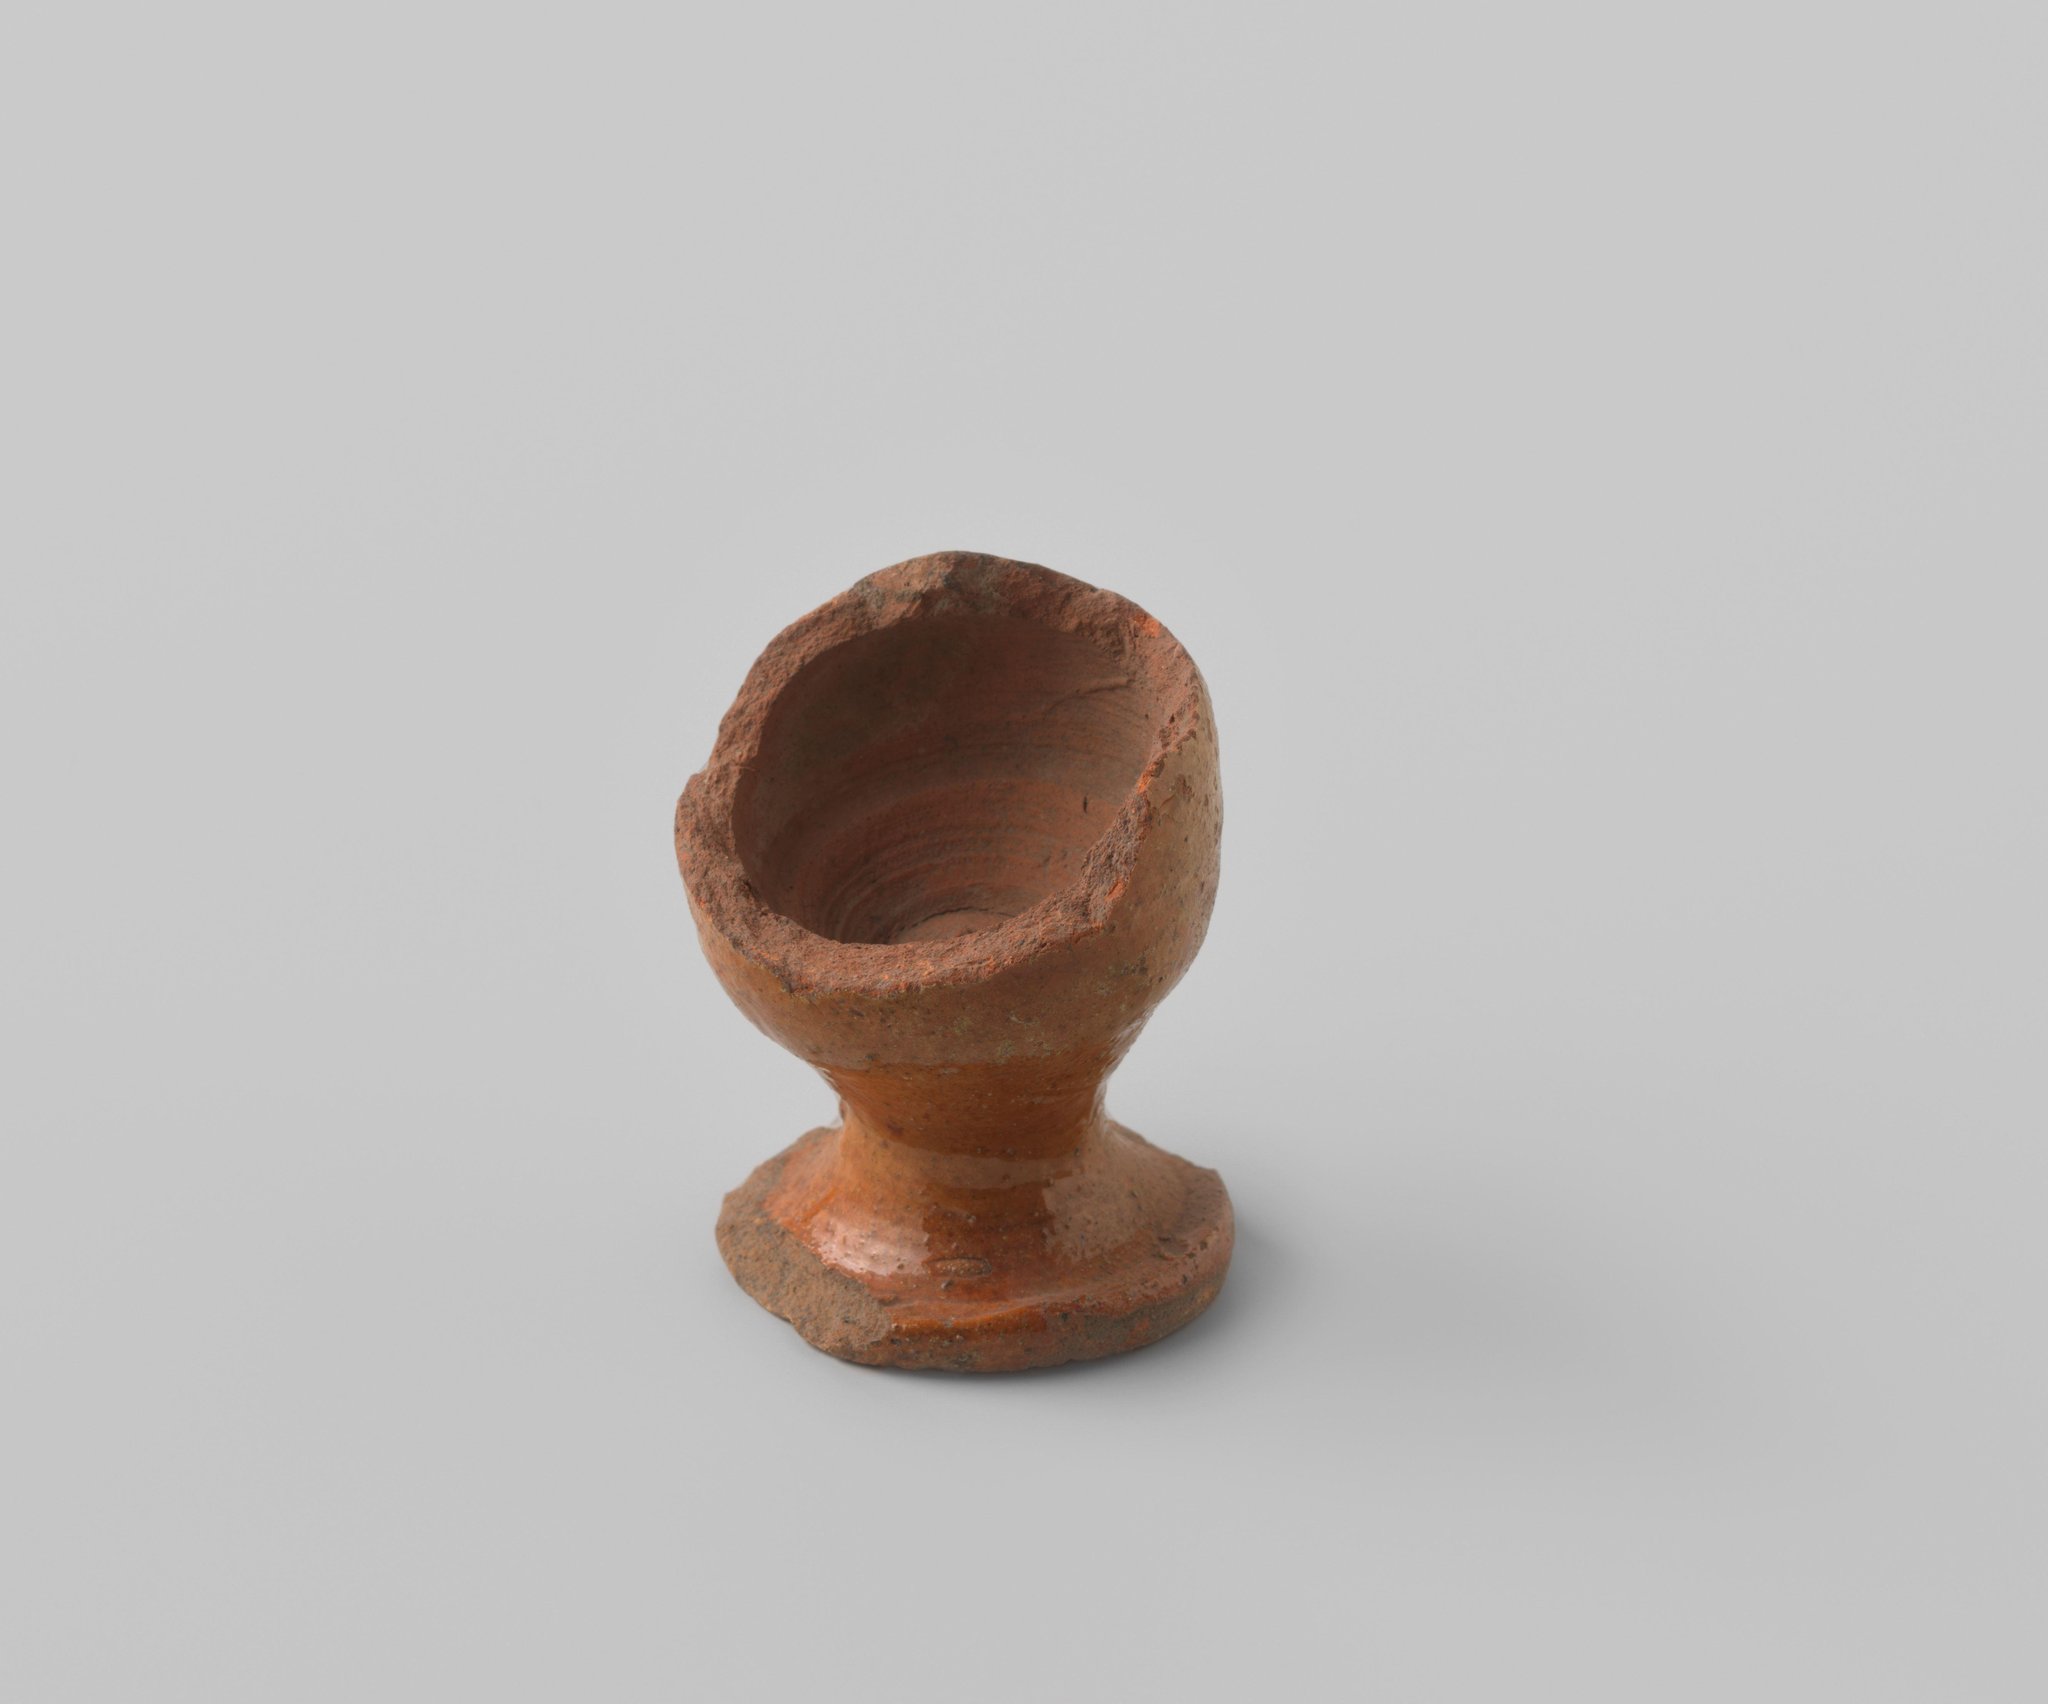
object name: sherd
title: Scherf met voet, van roodbakkend aardewerk, aan de buitenzijde voorzien van kleurloos glazuur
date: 1500-1899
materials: earthenware, glaze